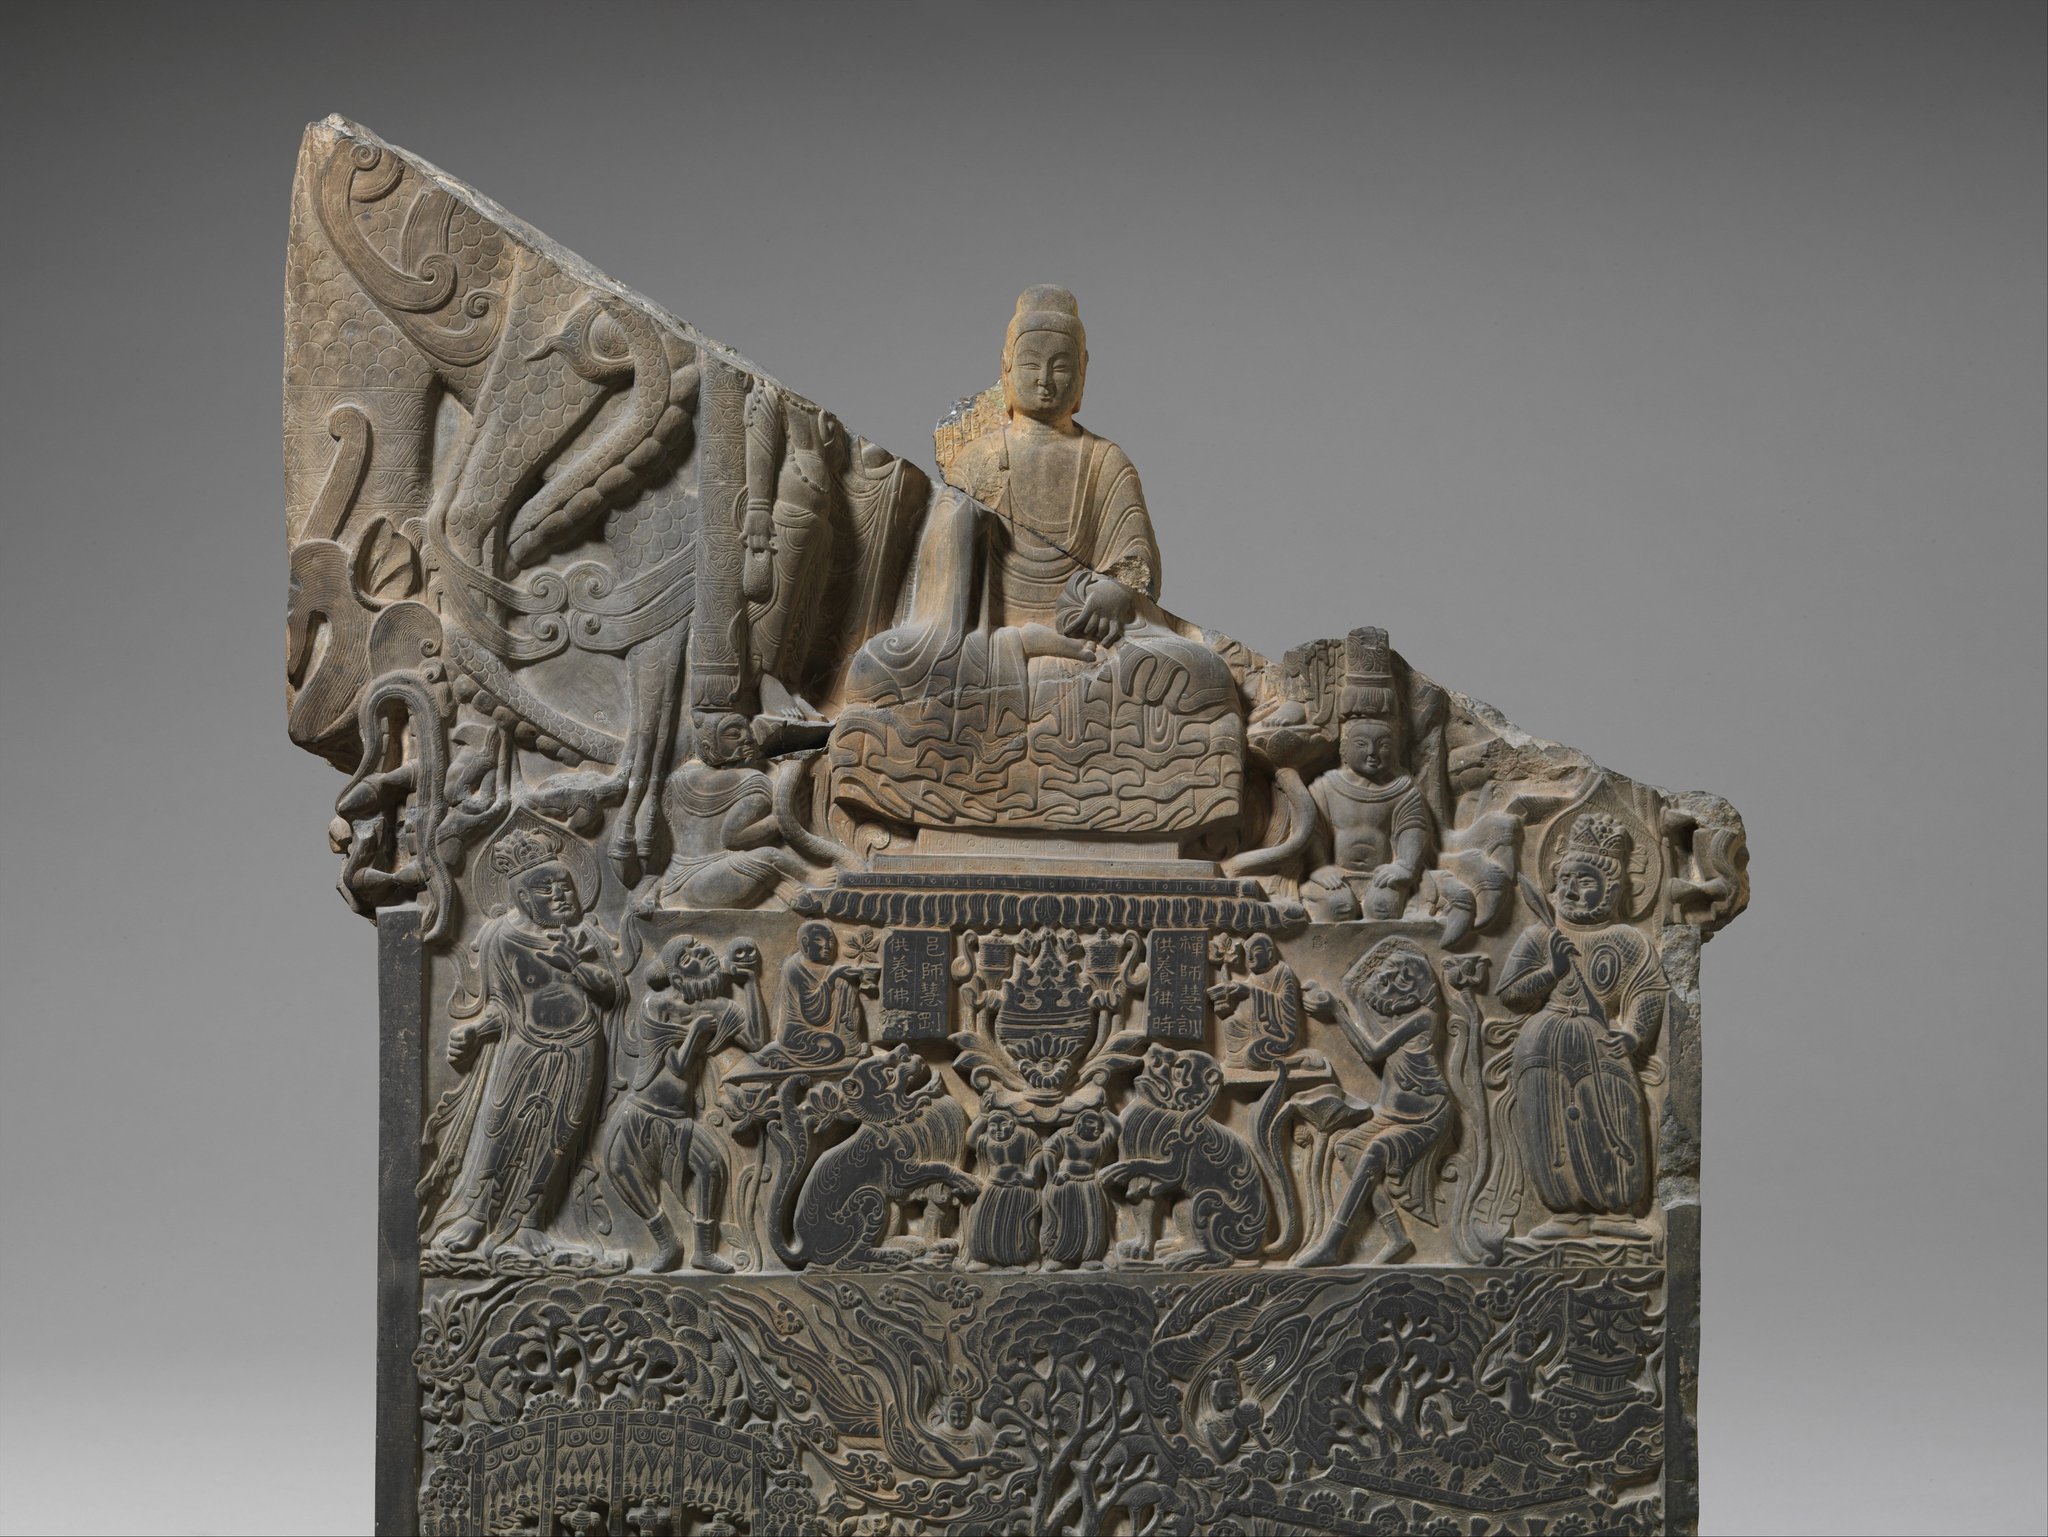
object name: stele fragment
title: Stele commissioned by Helian Ziyue (赫蓮子悅)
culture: chinese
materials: stone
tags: animals,buddha